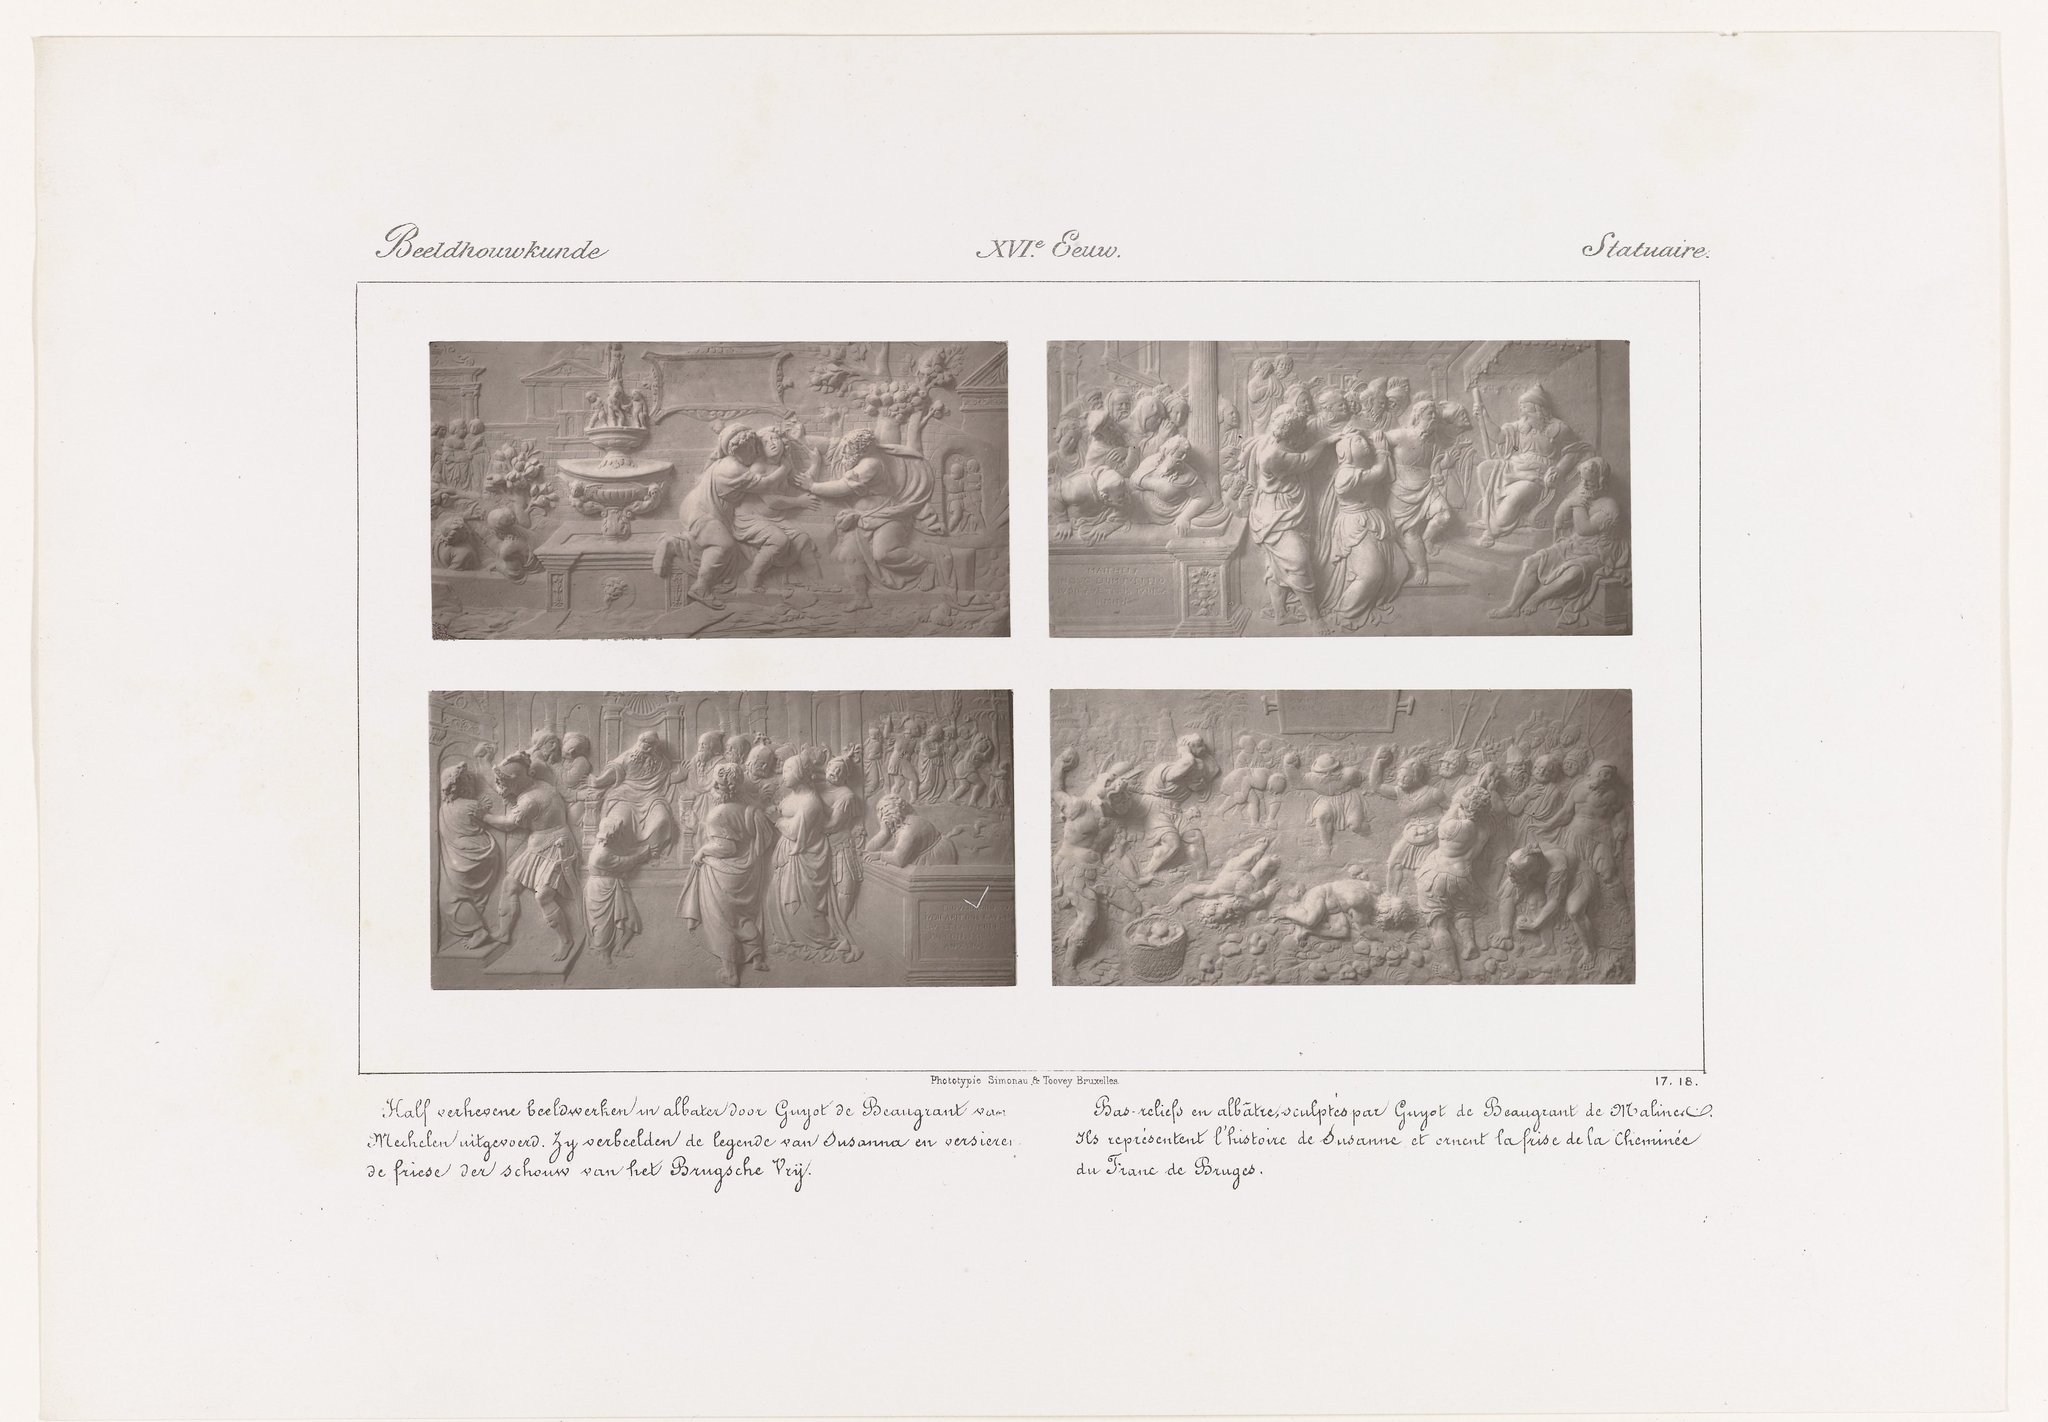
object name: photograph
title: Beeldhouwkunde XVI Eeuw Statuaire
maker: Anonymous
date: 1873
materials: paper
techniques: woodburytype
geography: antwerp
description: Ongenummerd blad met 4 Woodburytypieën. Blad uit 'Verzameling der overblijfsels onzer nationale kunst', 1873-1876.